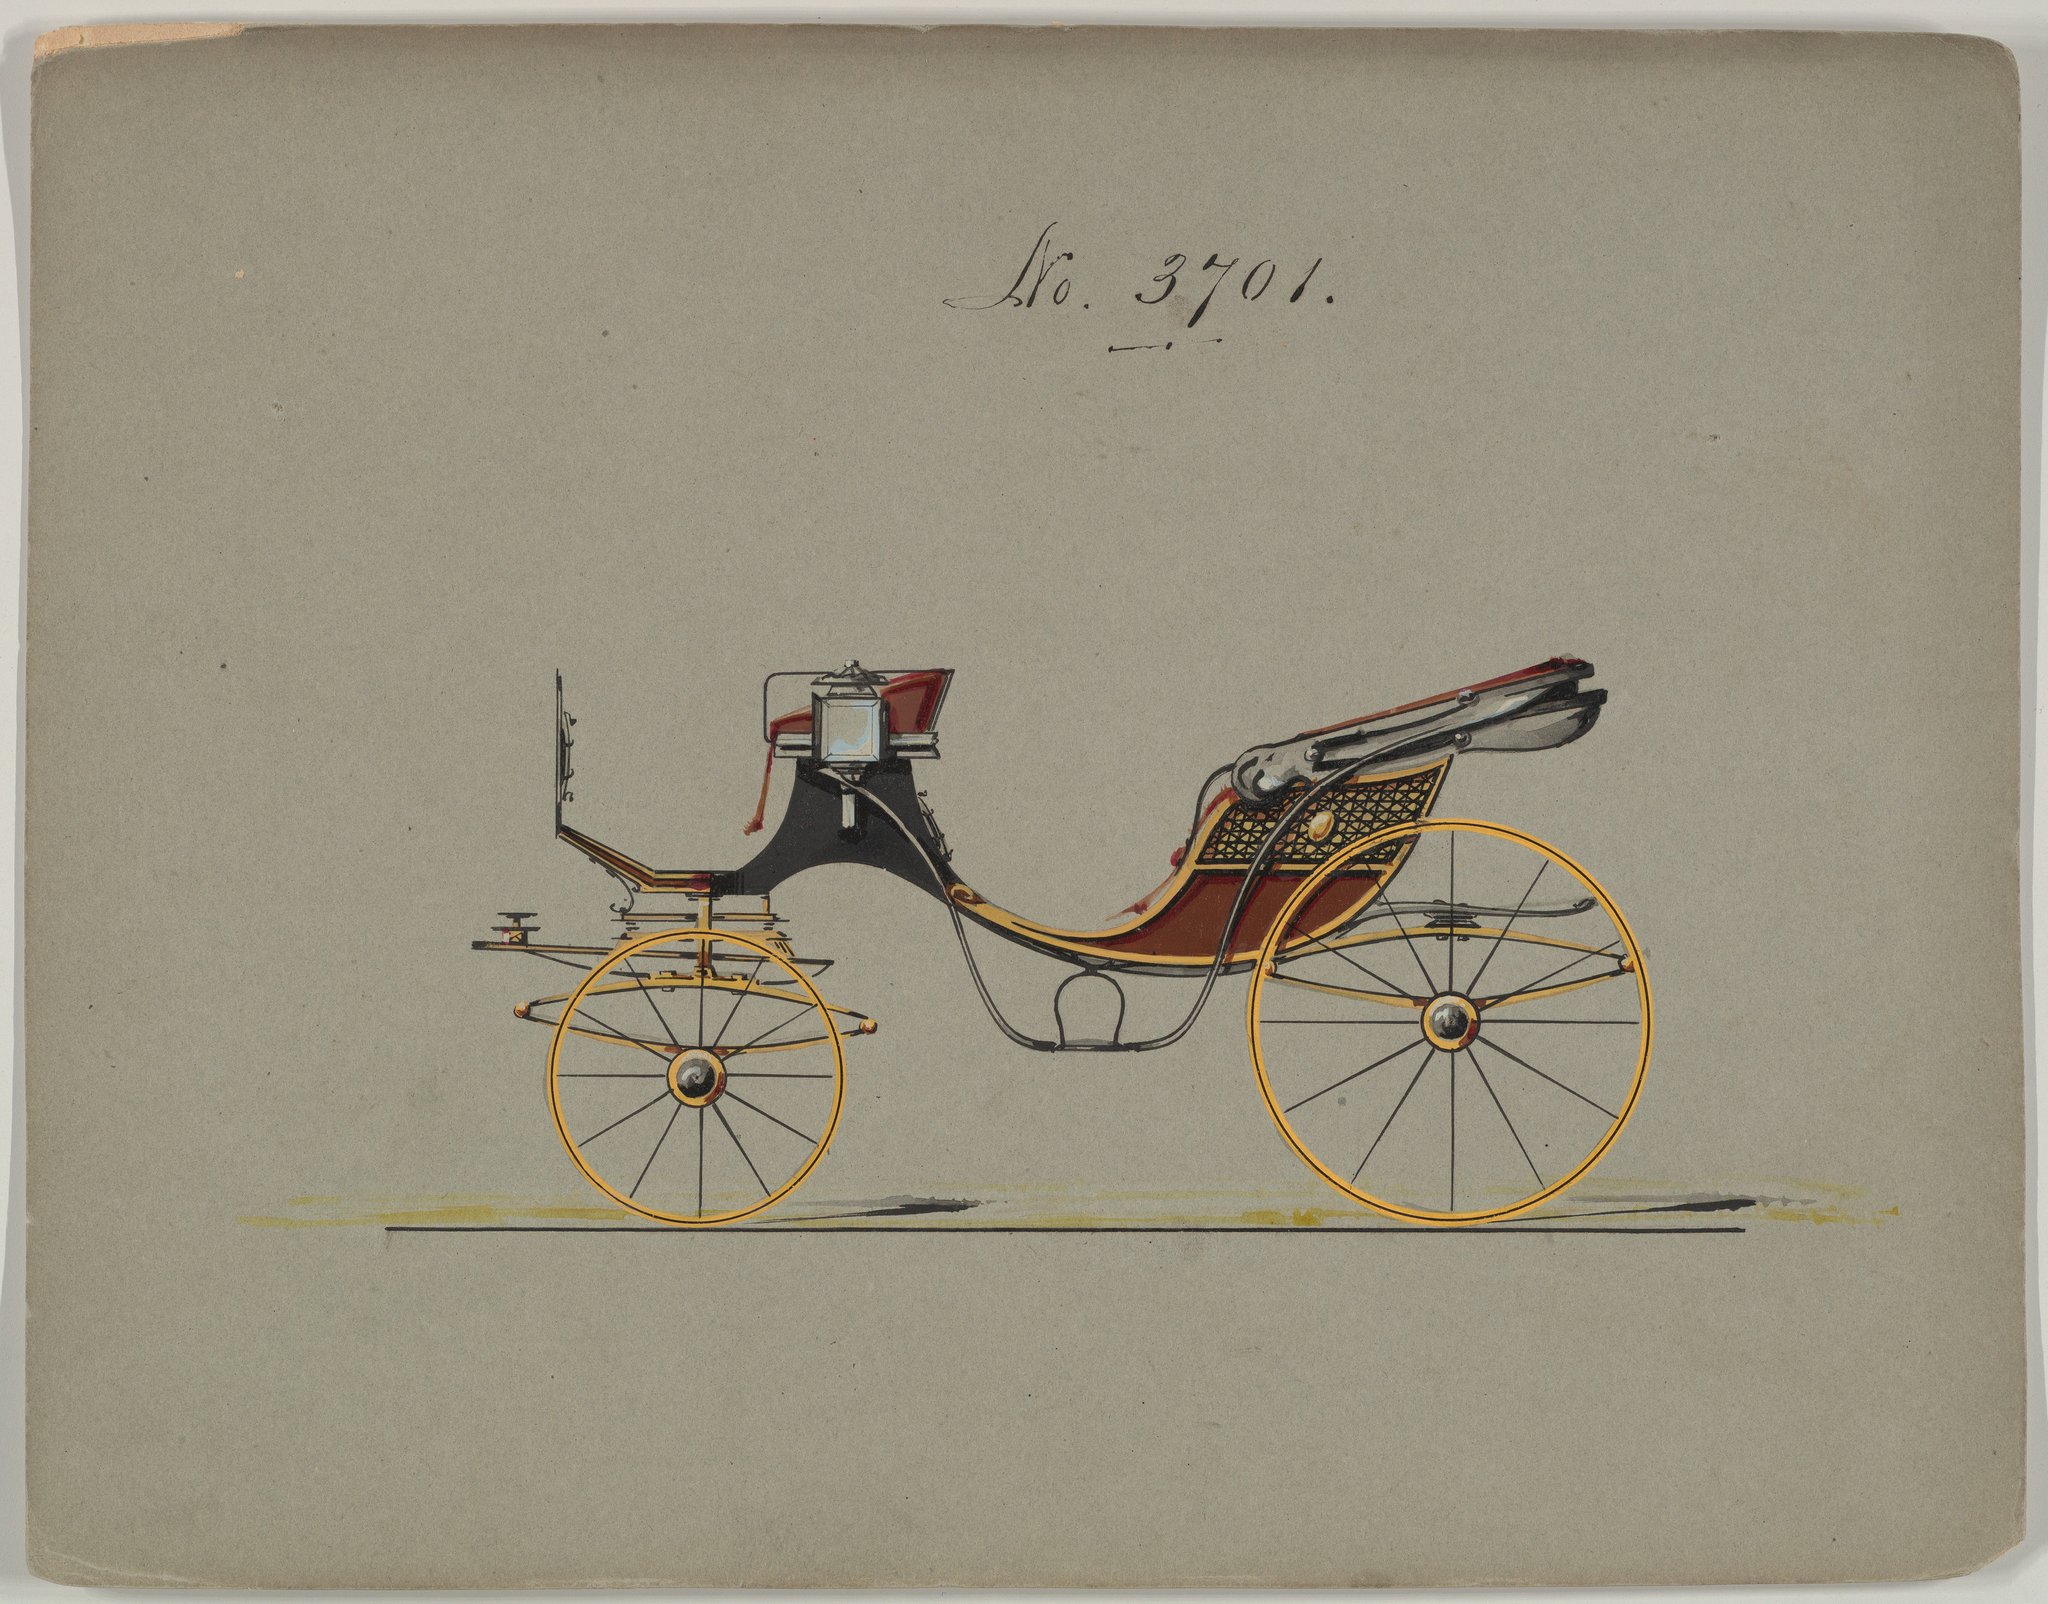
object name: drawing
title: Design for Cabriolet or Victoria, no. 3701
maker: brewster & co.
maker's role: manufacturer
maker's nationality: american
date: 1881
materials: gum arabic, ink, watercolor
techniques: pen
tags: carriages